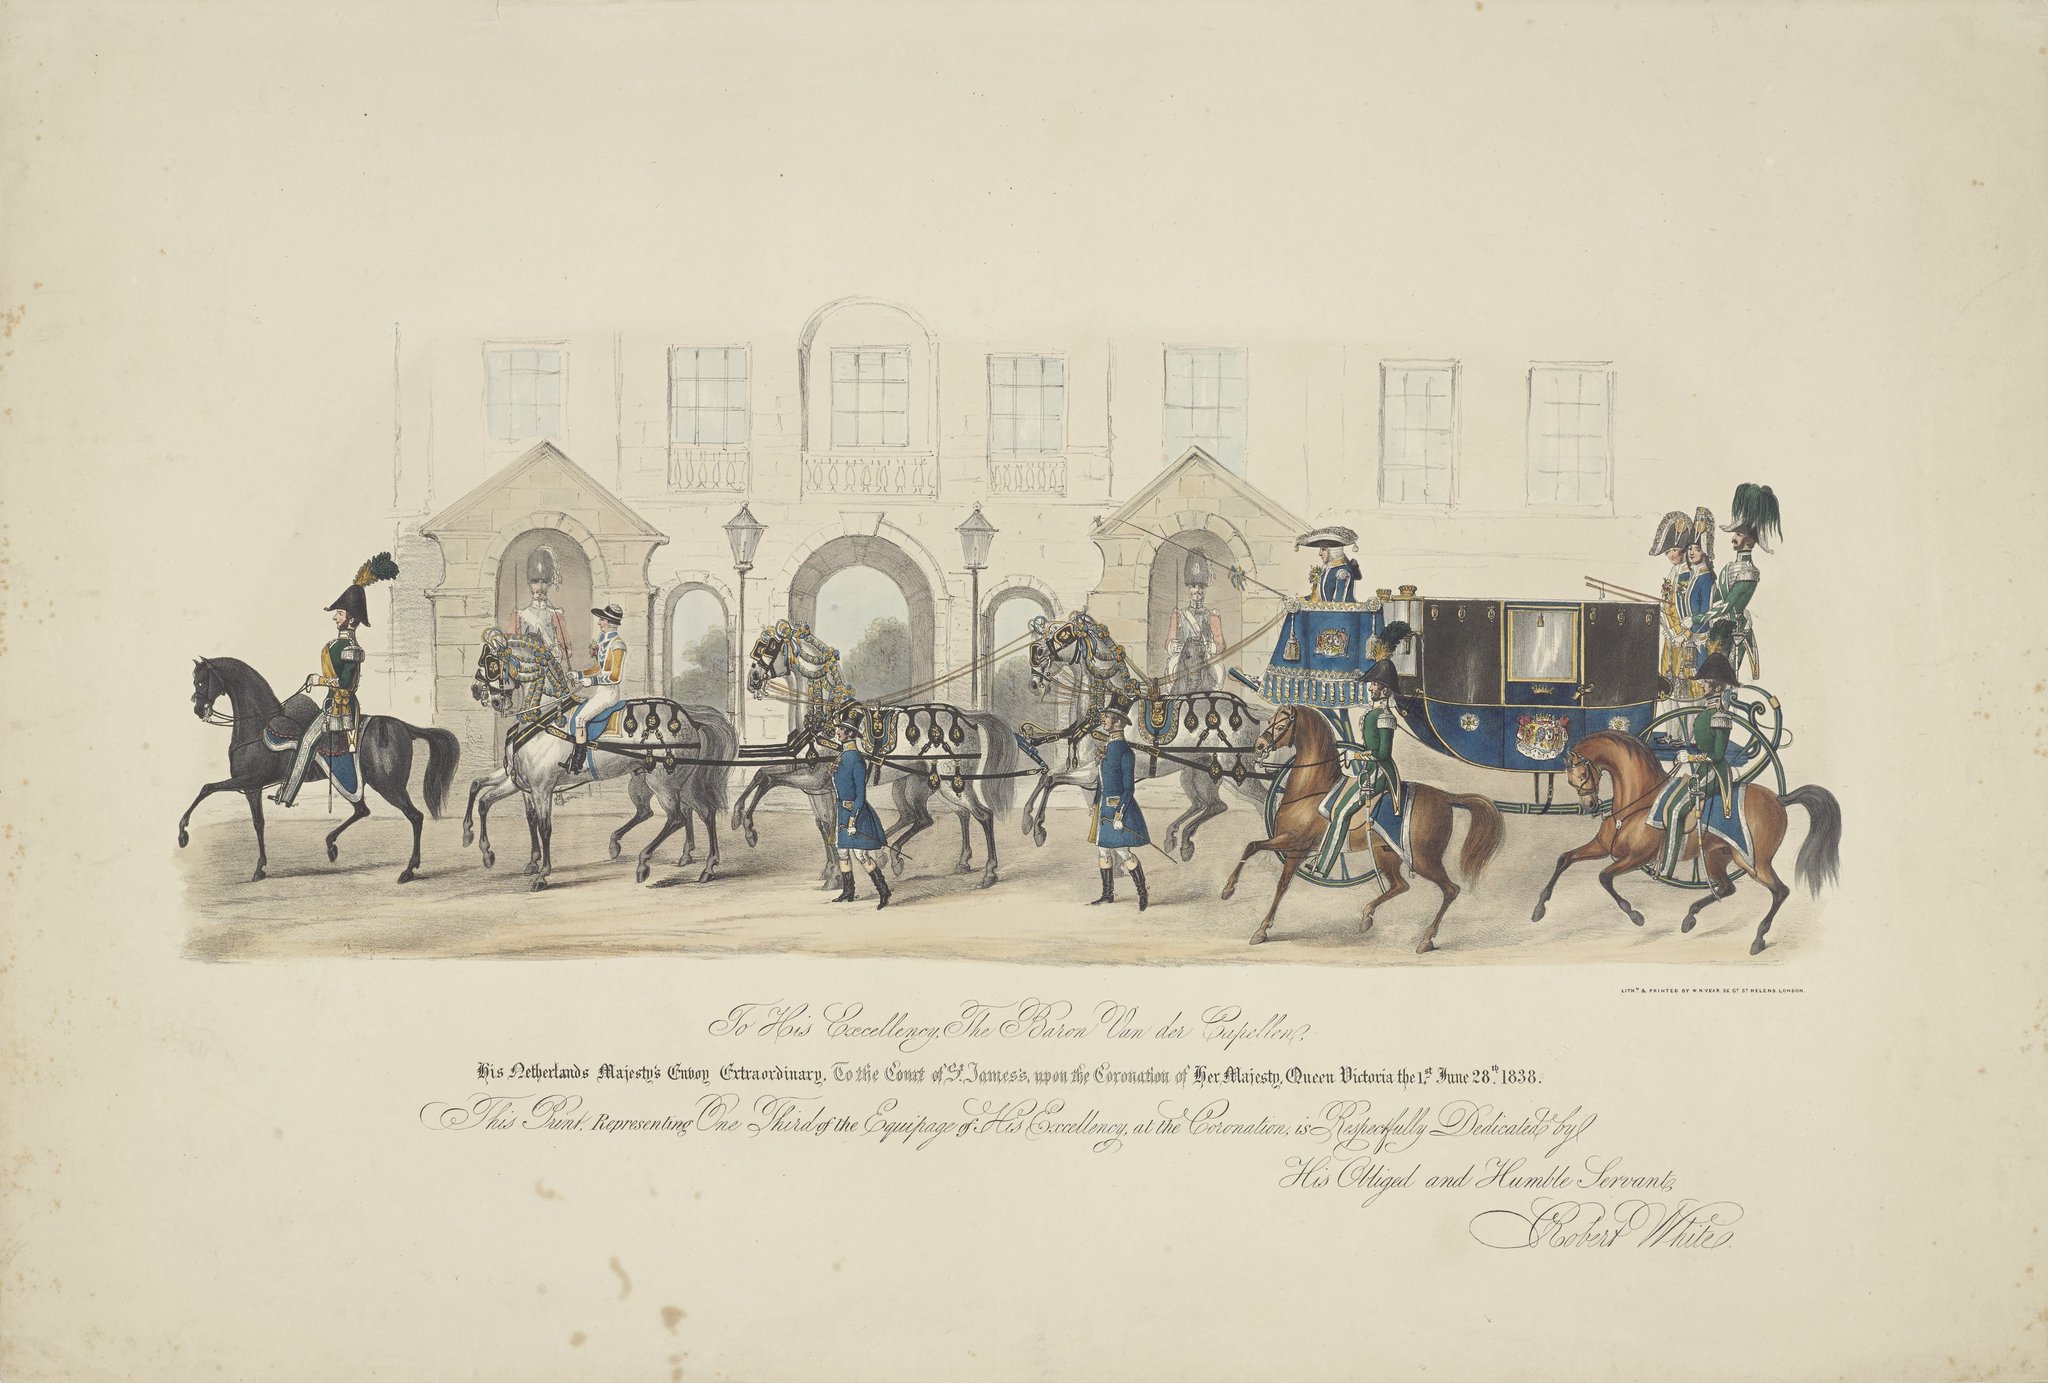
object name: print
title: To His Excellency, The Baron Van der Capellen, His Netherlands Majesty's Envoy Extraordinary, To the Court of St. James's, upon the Coronation of her Majesty, Queen Victoria the 1.st June 28th 1838. This Print, representing One Third of the Equipage of His Excellency, at the Coronation (...)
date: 1838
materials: paper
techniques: lithograph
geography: london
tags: victoria (koningin van het verenigd koninkrijk en keizerin van india), utrecht, godert alexander gerard philip capellen, coronation of a ruler, four-wheeled vehicle drawn by more than three animals, london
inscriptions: collector's mark: Lugt 2228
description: De met zes paarden bespannen galakoets met begeleiding waarmee de Nederlandse buitengewone gezant Godert Alexander Gerard Philip baron van der Capellen naar de kroning van koningin Victoria is gebracht in Londen op 1 juni 1838.